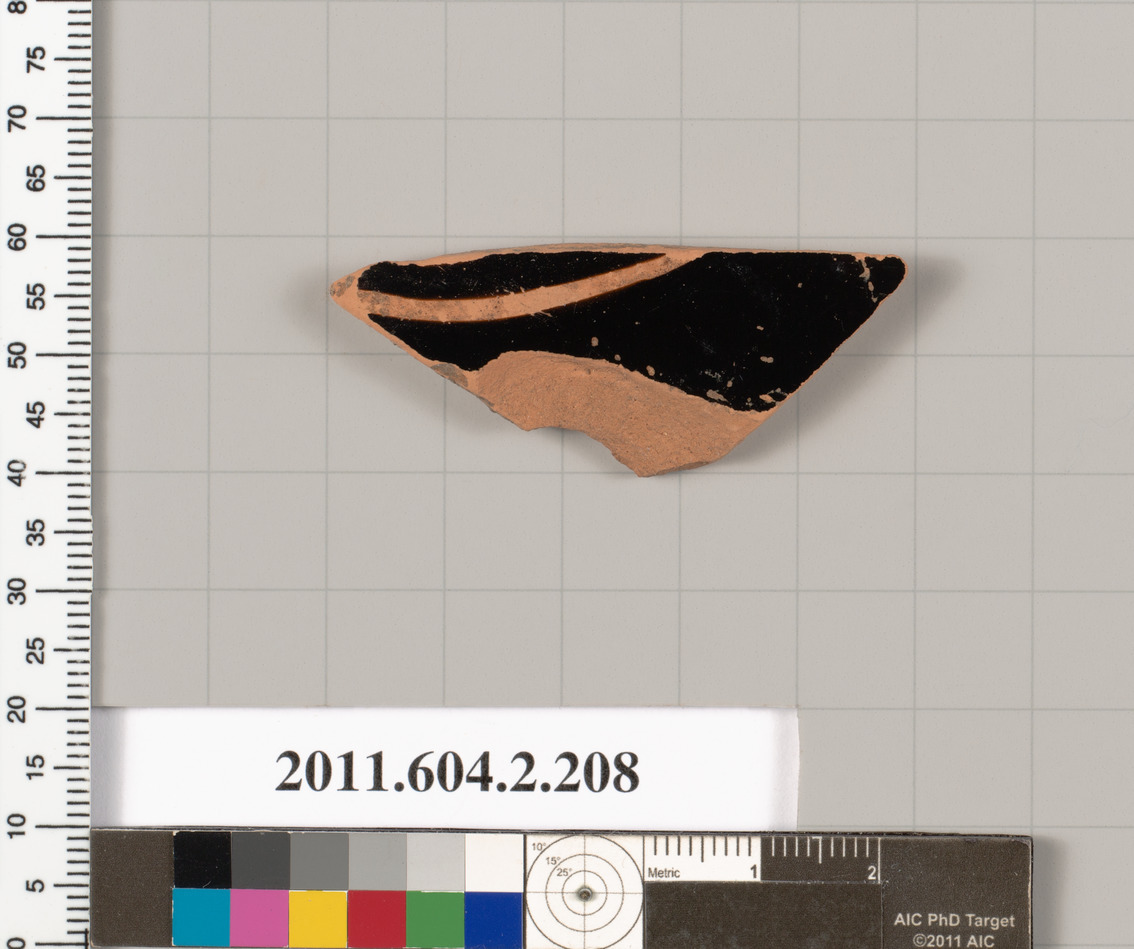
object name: stamnos fragment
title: Terracotta fragment of a stamnos (jar)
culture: greek, attic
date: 520-490 BCE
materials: terracotta